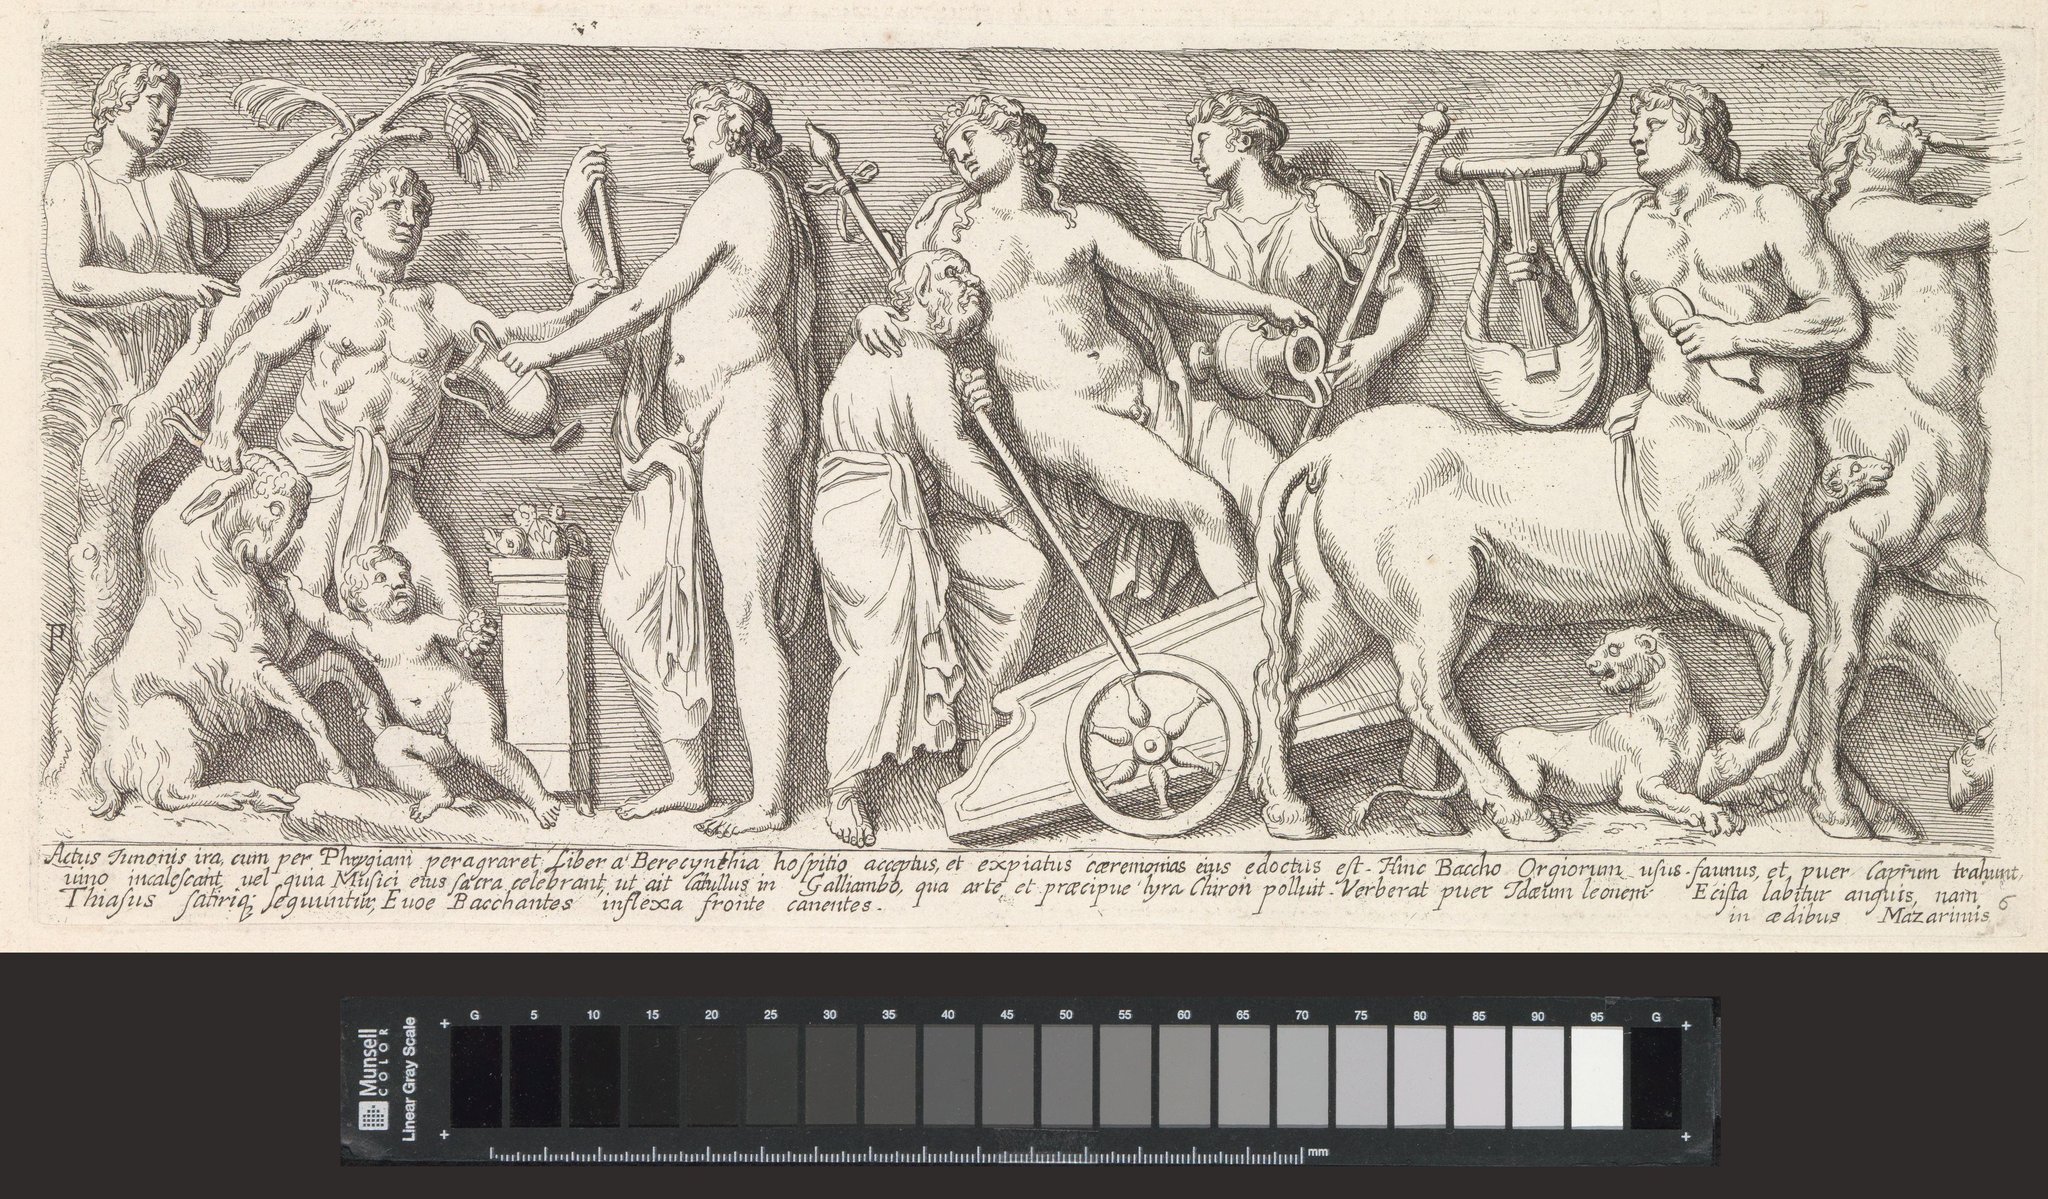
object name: print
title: Romeinse gebeeldhouwde reliëfs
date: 1645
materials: paper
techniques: etching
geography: vatican city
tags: centaurs, triumph of bacchus; 'carro di bacco' (ripa), piece of sculpture, reproduction of a piece of sculpture, satyr(s) (in general), cupids: 'amores', 'amoretti', 'putti'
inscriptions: number: ‘33’, inscription: ‘Ende lib. No. 1. fol. 55./ Ende lib. No. 4...’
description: Deze prent maakt deel uit van een reeks van 54 prenten (+ titelprent) naar antieke reliëfs. De nummering op de prenten loopt van 1 tot en met 50. Sommige prenten hebben dubbele nummers. Naar een reliëf in Palazzo Rospigliosi-Pallavicini te Rome.